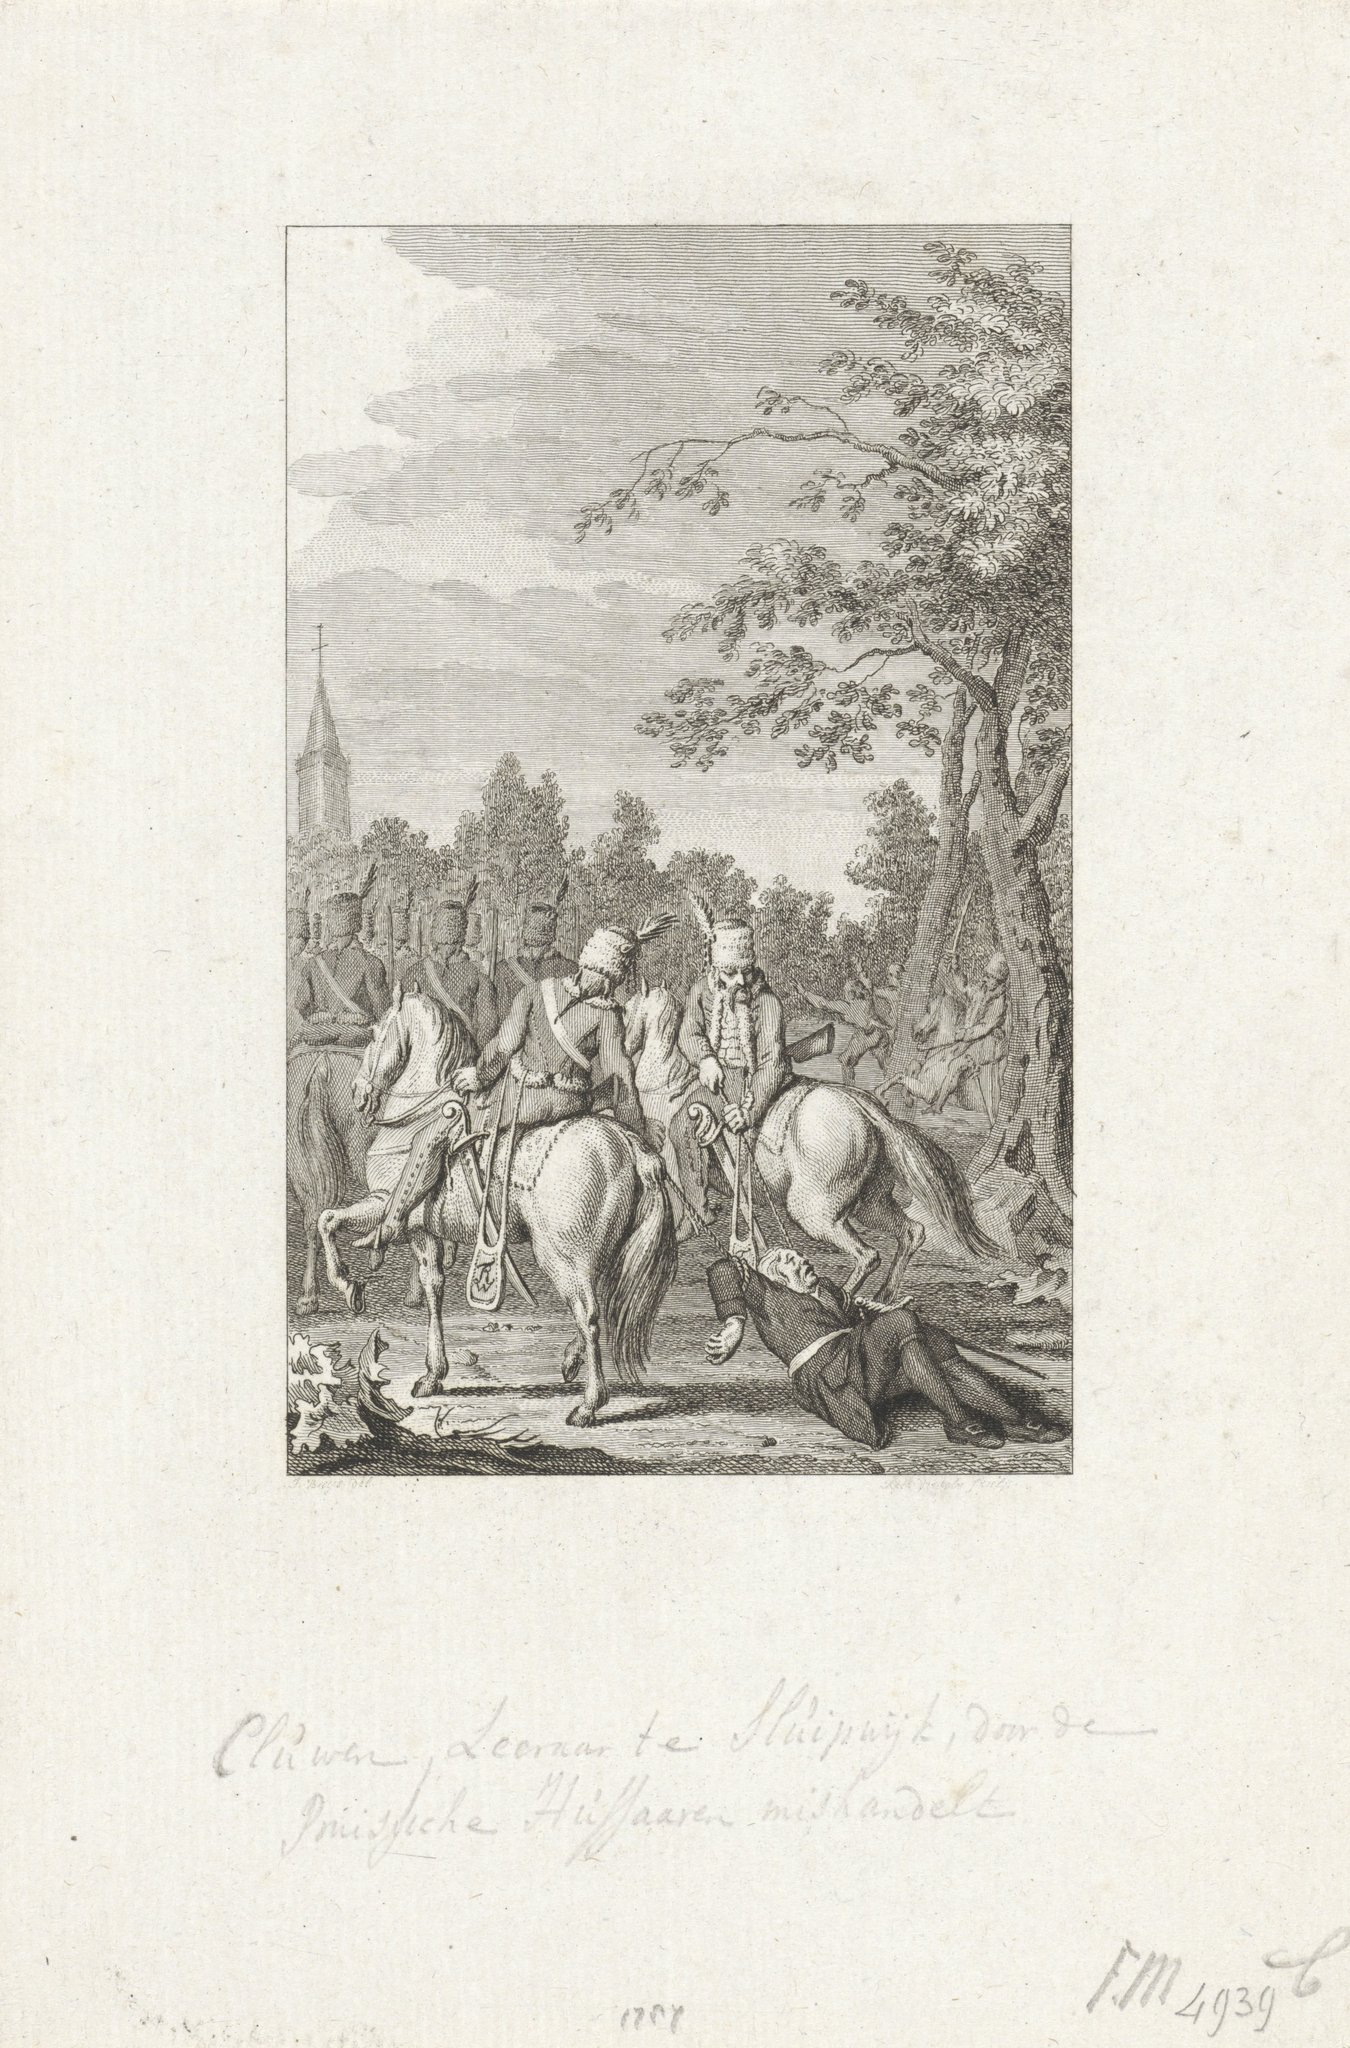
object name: history print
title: Mishandeling van dominee Cluwen te Sluipwijk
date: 1796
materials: paper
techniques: engraving, etching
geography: amsterdam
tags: soldiers and civilians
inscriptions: collector's mark: Lugt 240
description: Gebruikt als illustratie in: P.A. Loosjes. Vaderlandsche historie, vervattende de geschiedenissen, der Vereenigde Nederlanden (...). Ten onmiddelyken vervolge van Wagenaar's Vaderlandsche historie. Amsterdam: Johannes Allart, dl. 17.